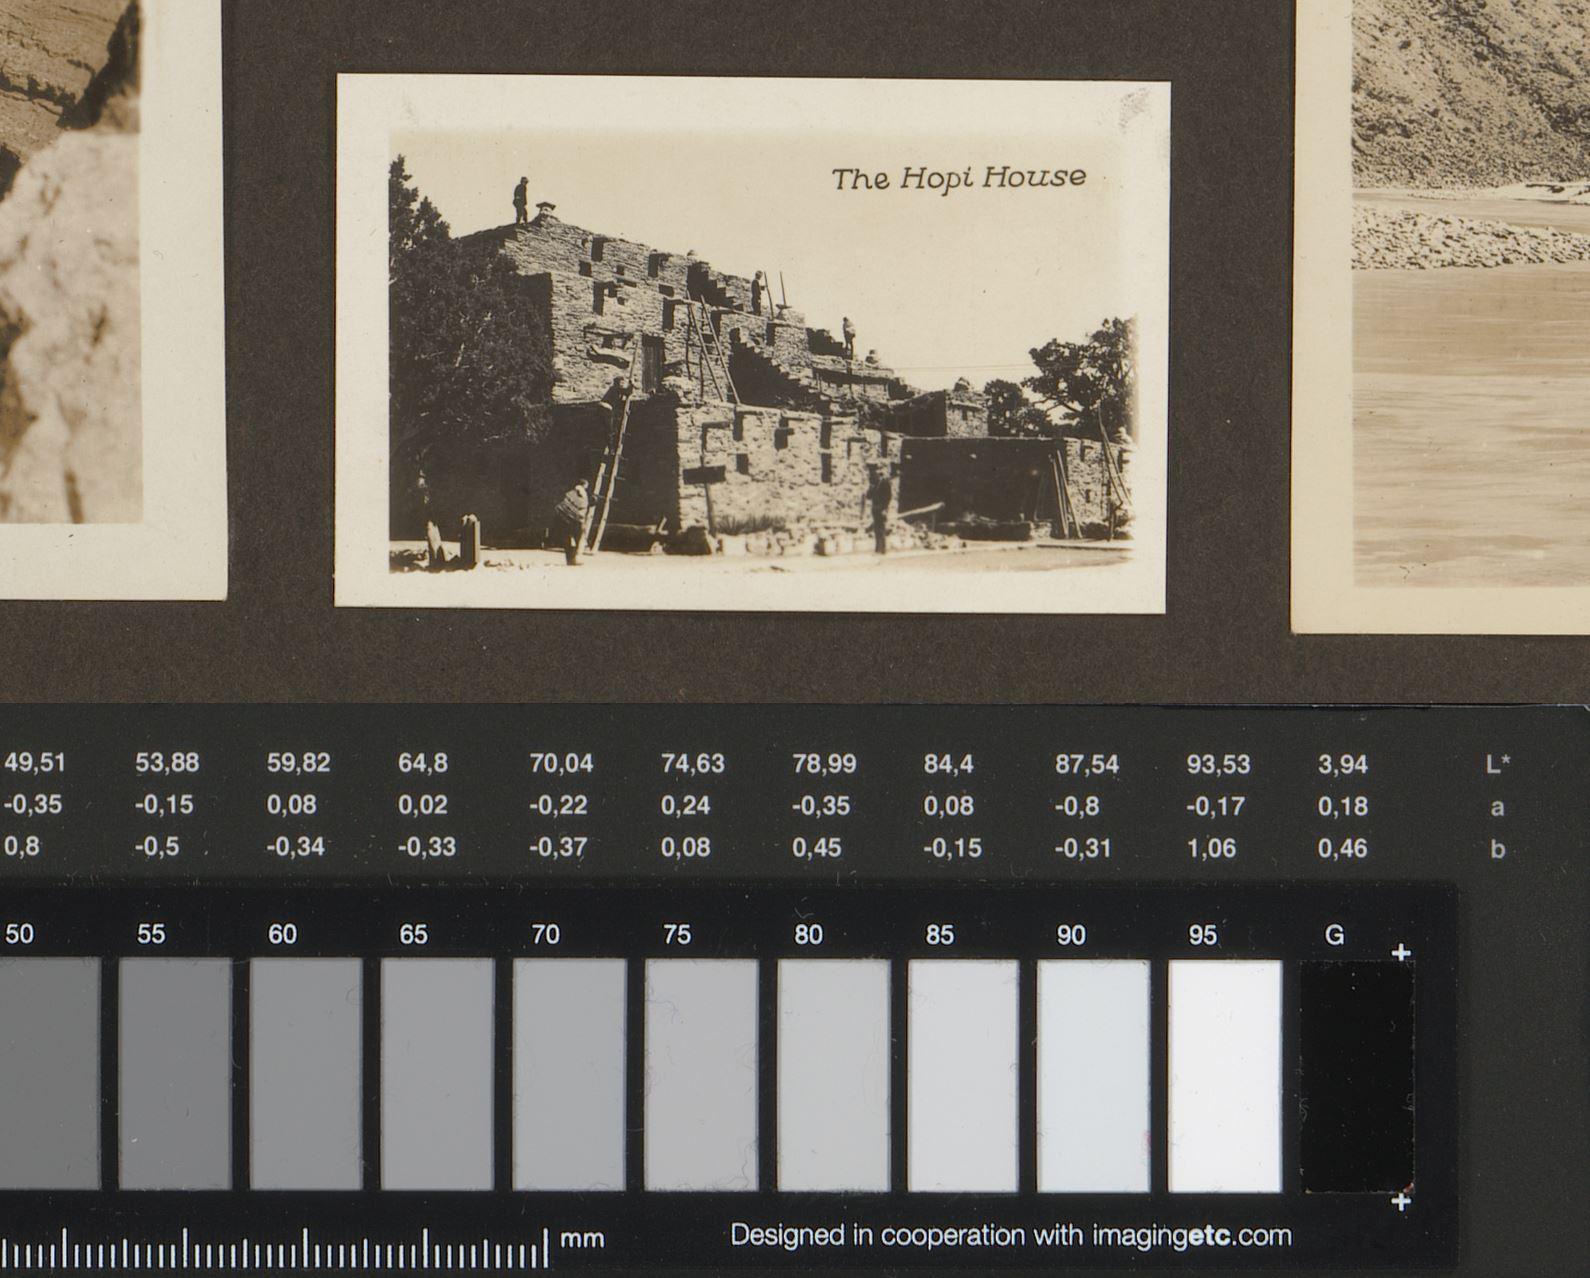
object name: album leaf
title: Gezicht op Hopt House in de Grand Canyon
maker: Anonymous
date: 1928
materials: photographic support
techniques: gelatin silver print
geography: grand canyon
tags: civic architecture; edifices; dwellings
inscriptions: annotation: ‘Grand Canyon’